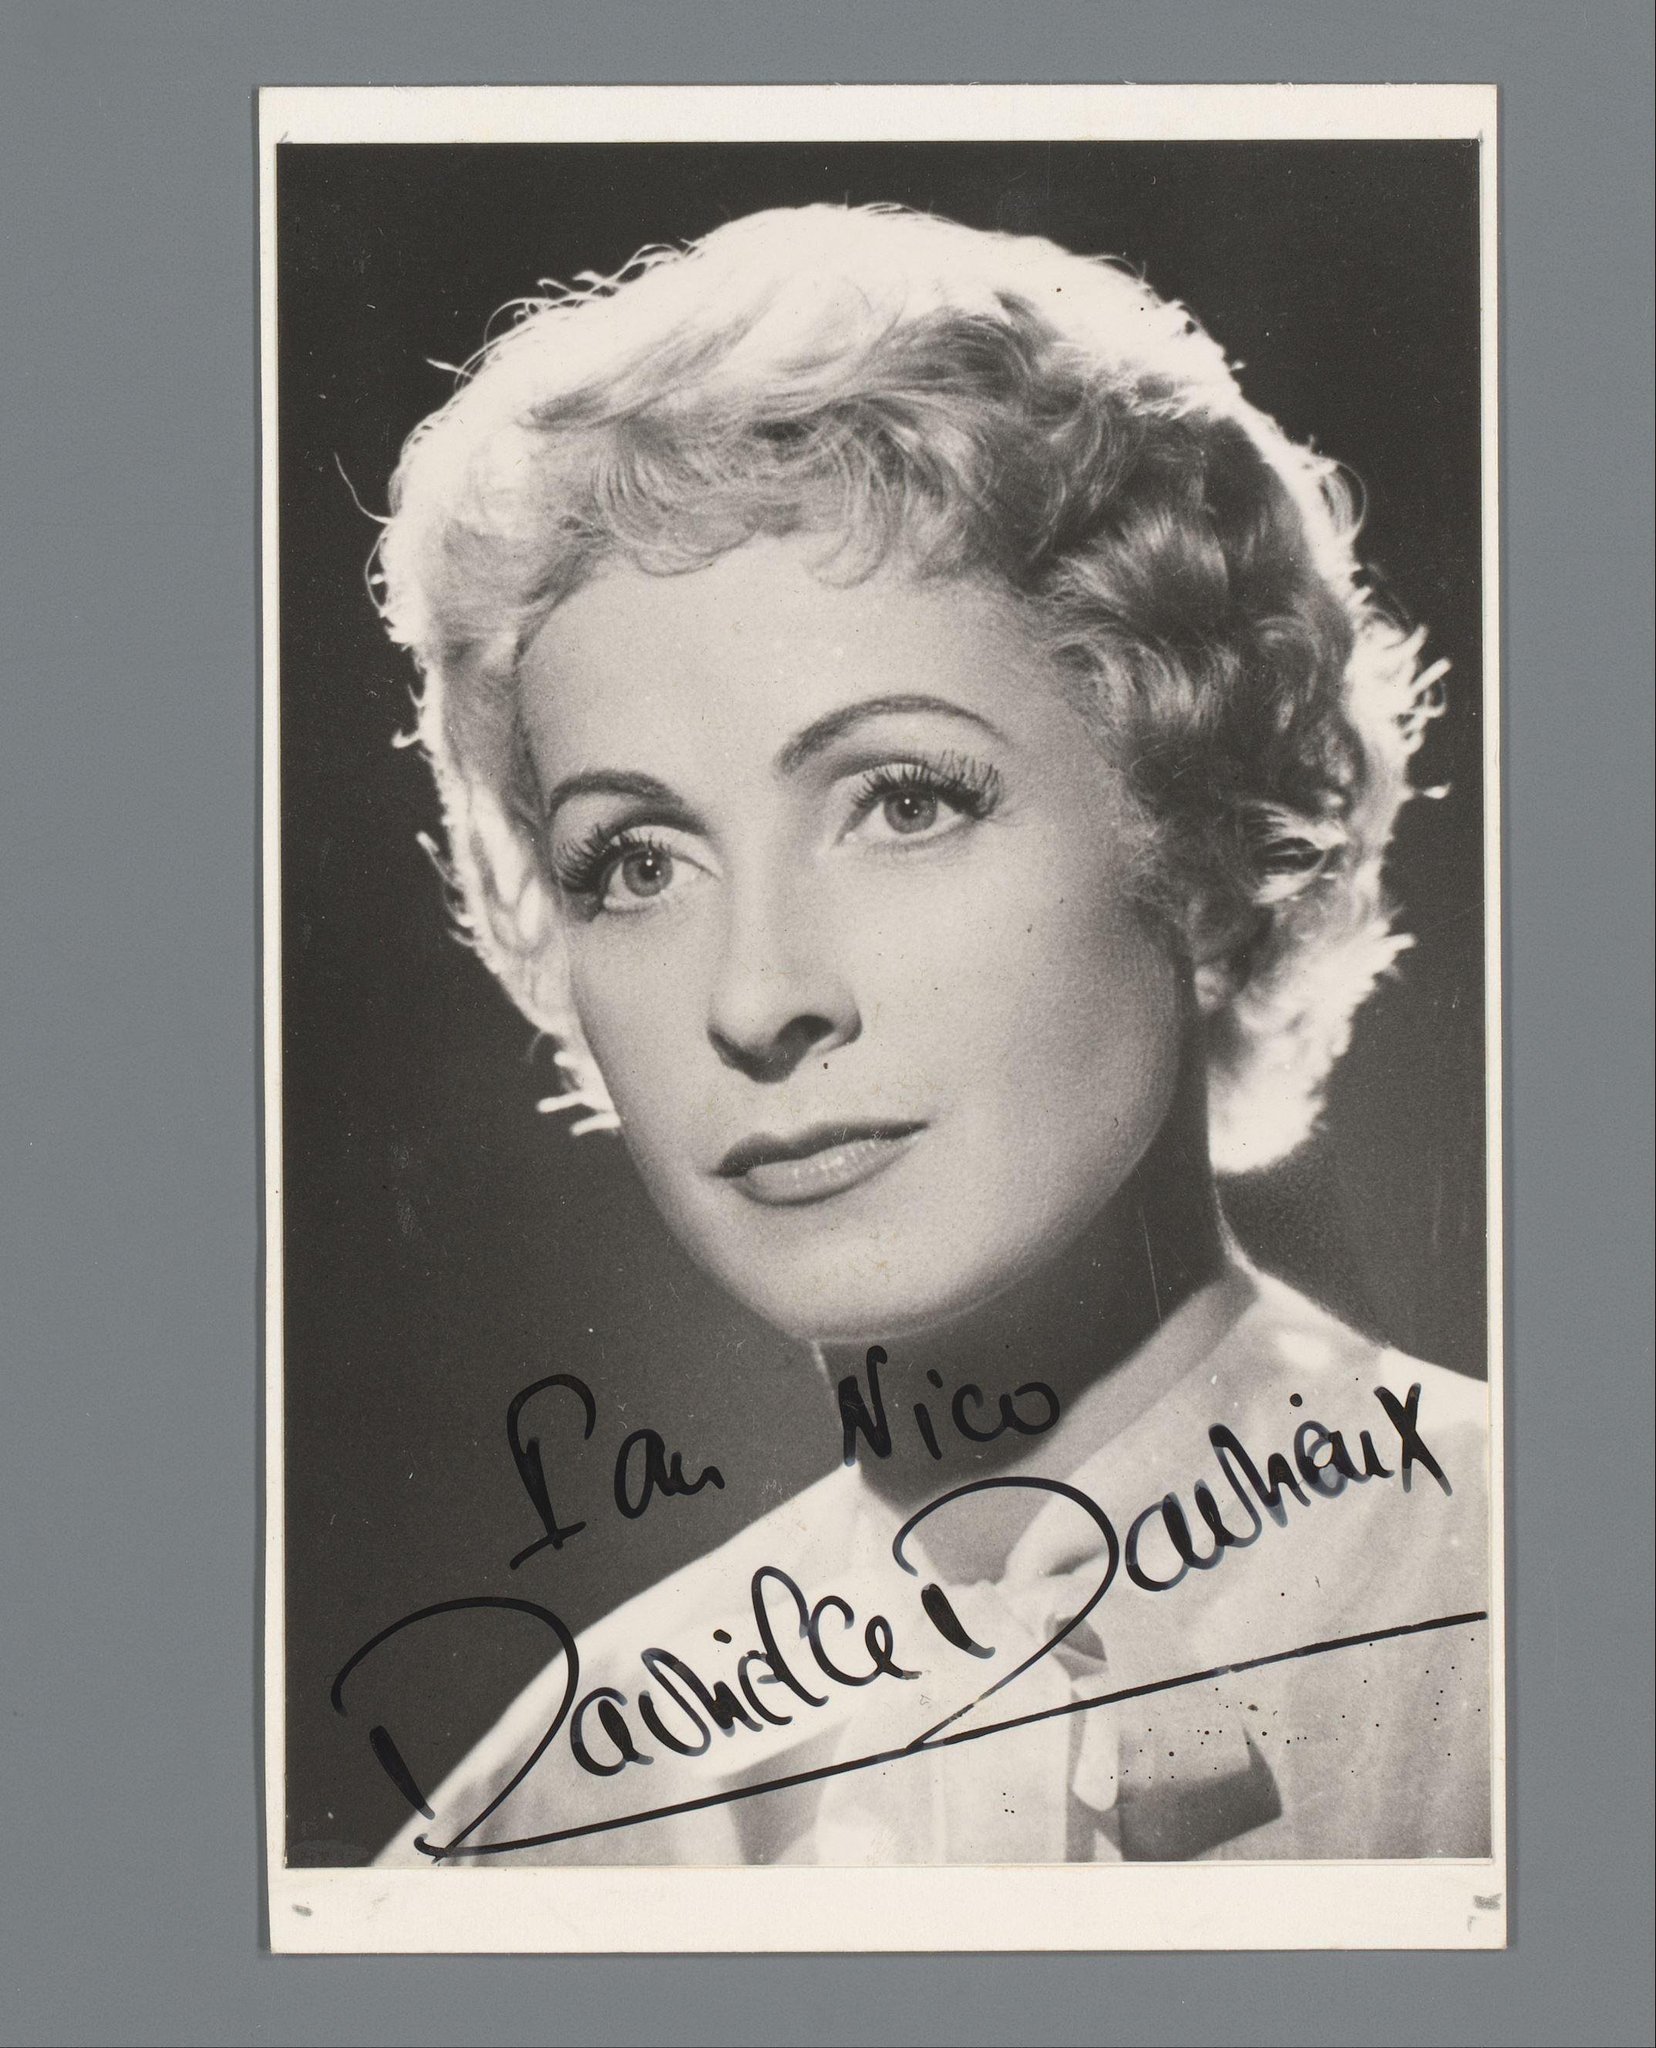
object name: photograph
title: Foto van actrice Danielle Darrieux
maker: Anonymous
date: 1950-1960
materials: paper, cardboard, ink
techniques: gelatin silver print, pen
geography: france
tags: portrait of actor, actress, france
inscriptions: inscription: ‘Pour Nico/ Danielle Darrieux’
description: Gesigneerd en met opdracht voor Nico Meijer.